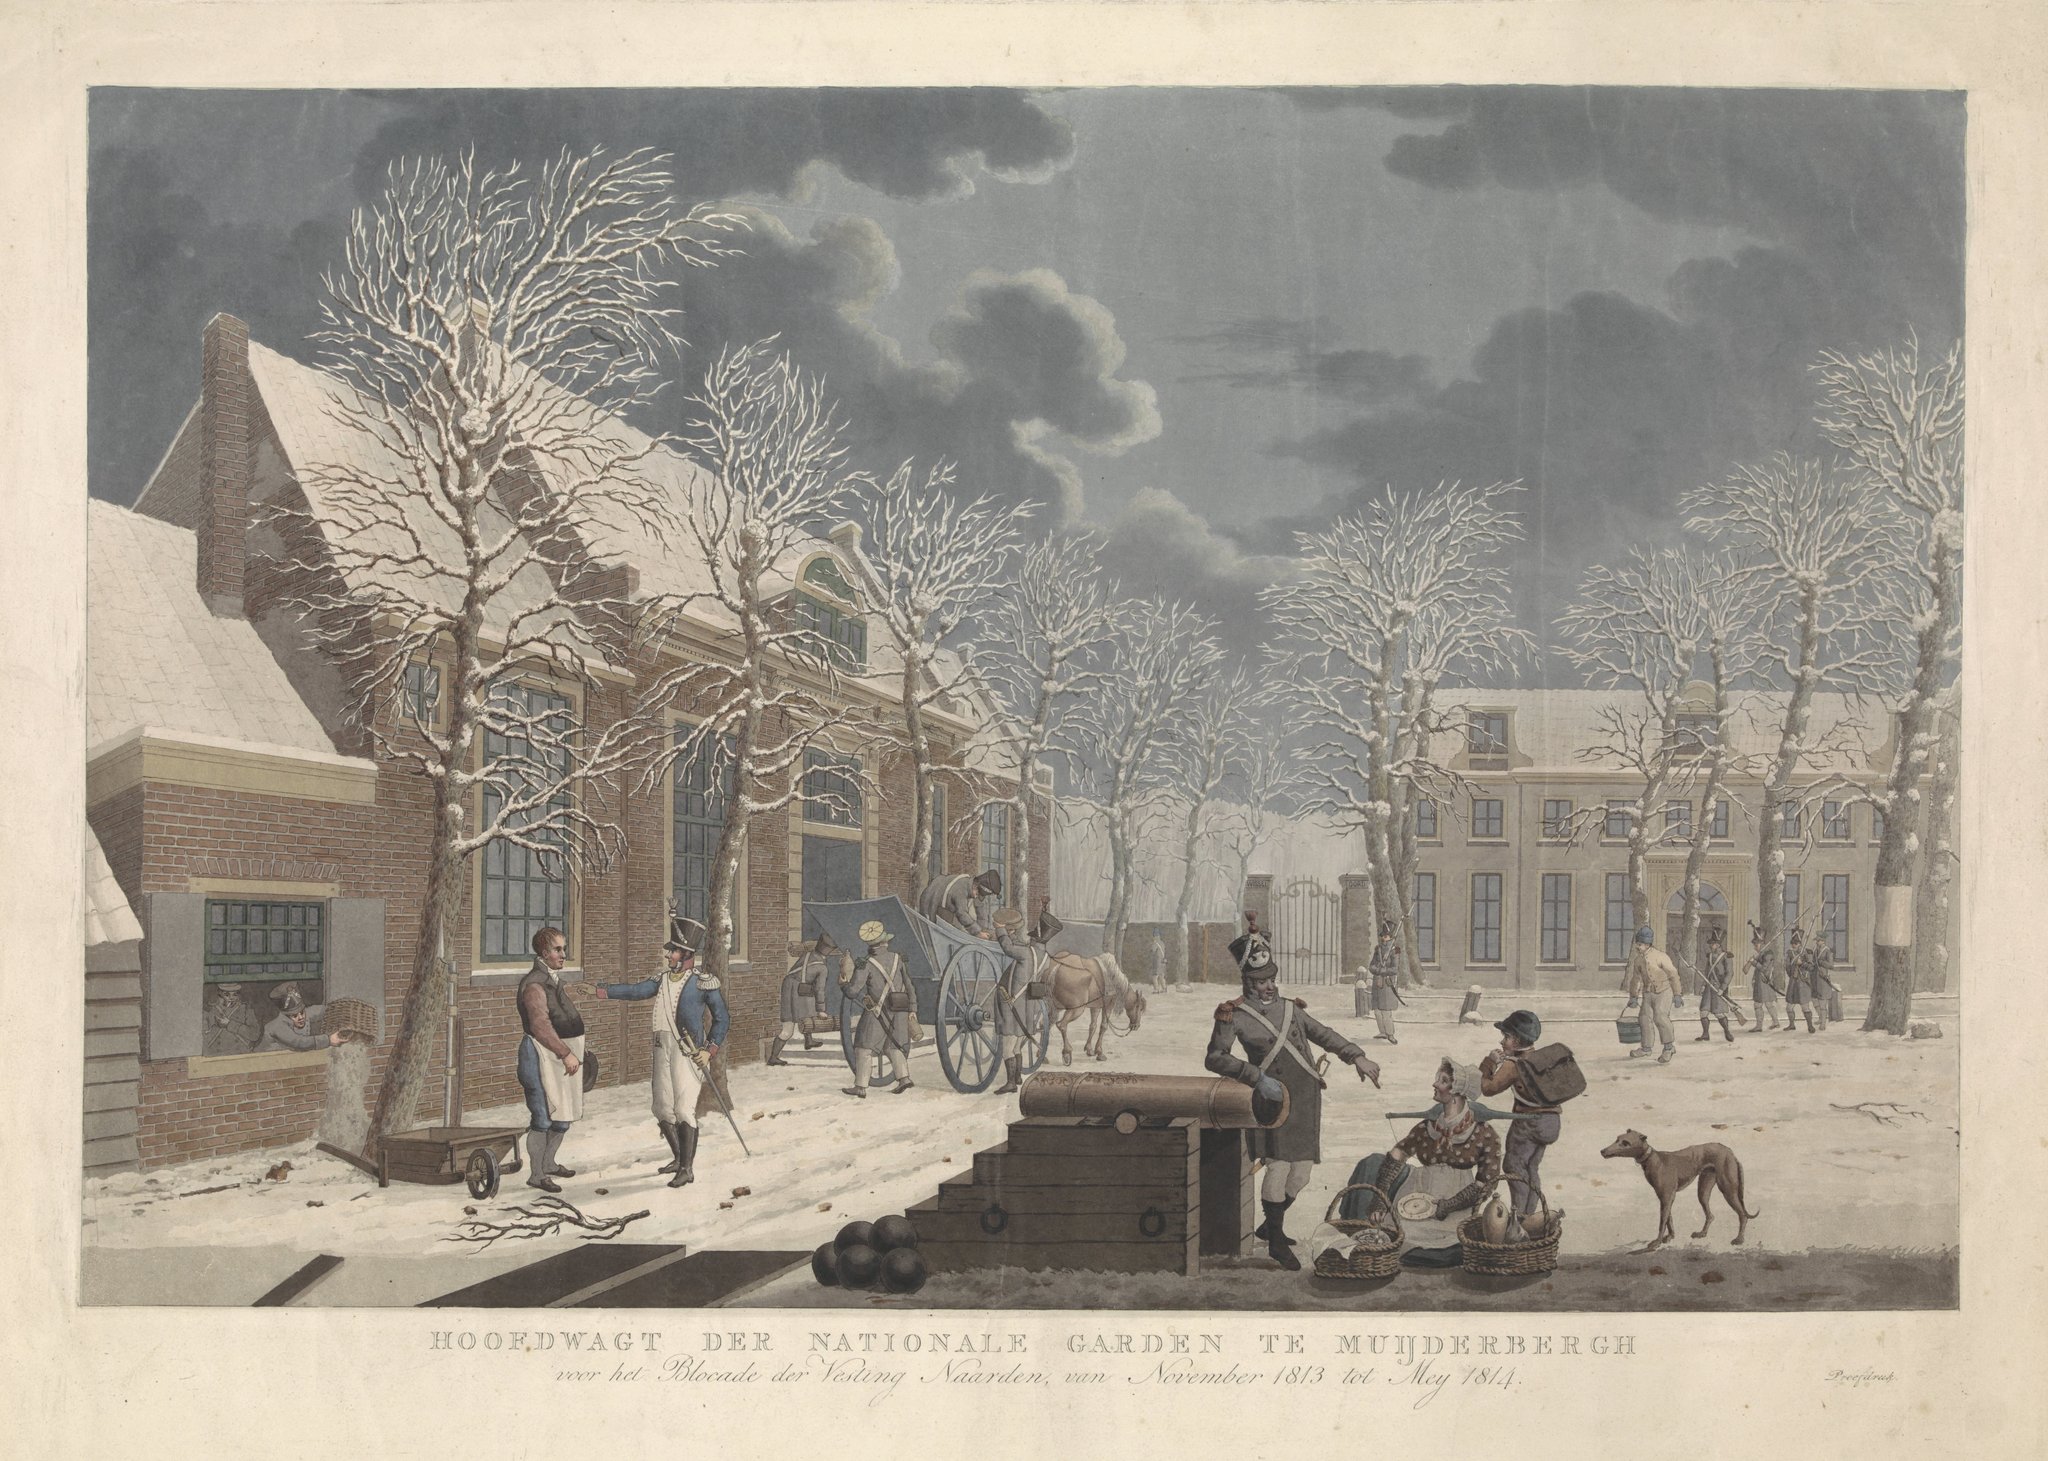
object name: print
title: Hoofdwagt der nationale garden te Muijderbergh voor het Blocade der vesting Naarden, van November 1813 tot Mey 1814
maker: willem hendrik hoogkamer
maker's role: draughtsman, print maker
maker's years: 1790-1864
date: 1814-1816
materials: paper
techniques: aquatint, etching, hand coloring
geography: netherlands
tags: firearms: cannon, soldiers and civilians, snow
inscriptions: collector's mark: Lugt 2233, collector's mark: Lugt 1105a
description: Soldaten in de sneeuw tijdens het beleg van Naarden. Een soldaat bij een kanon vraagt een vrouw om eten; zij heeft een juk op haar schouders en knielt neer om eten uit een van haar manden op een bord te doen. Links een soldaat in gesprek met een man, een kar wordt ontladen.